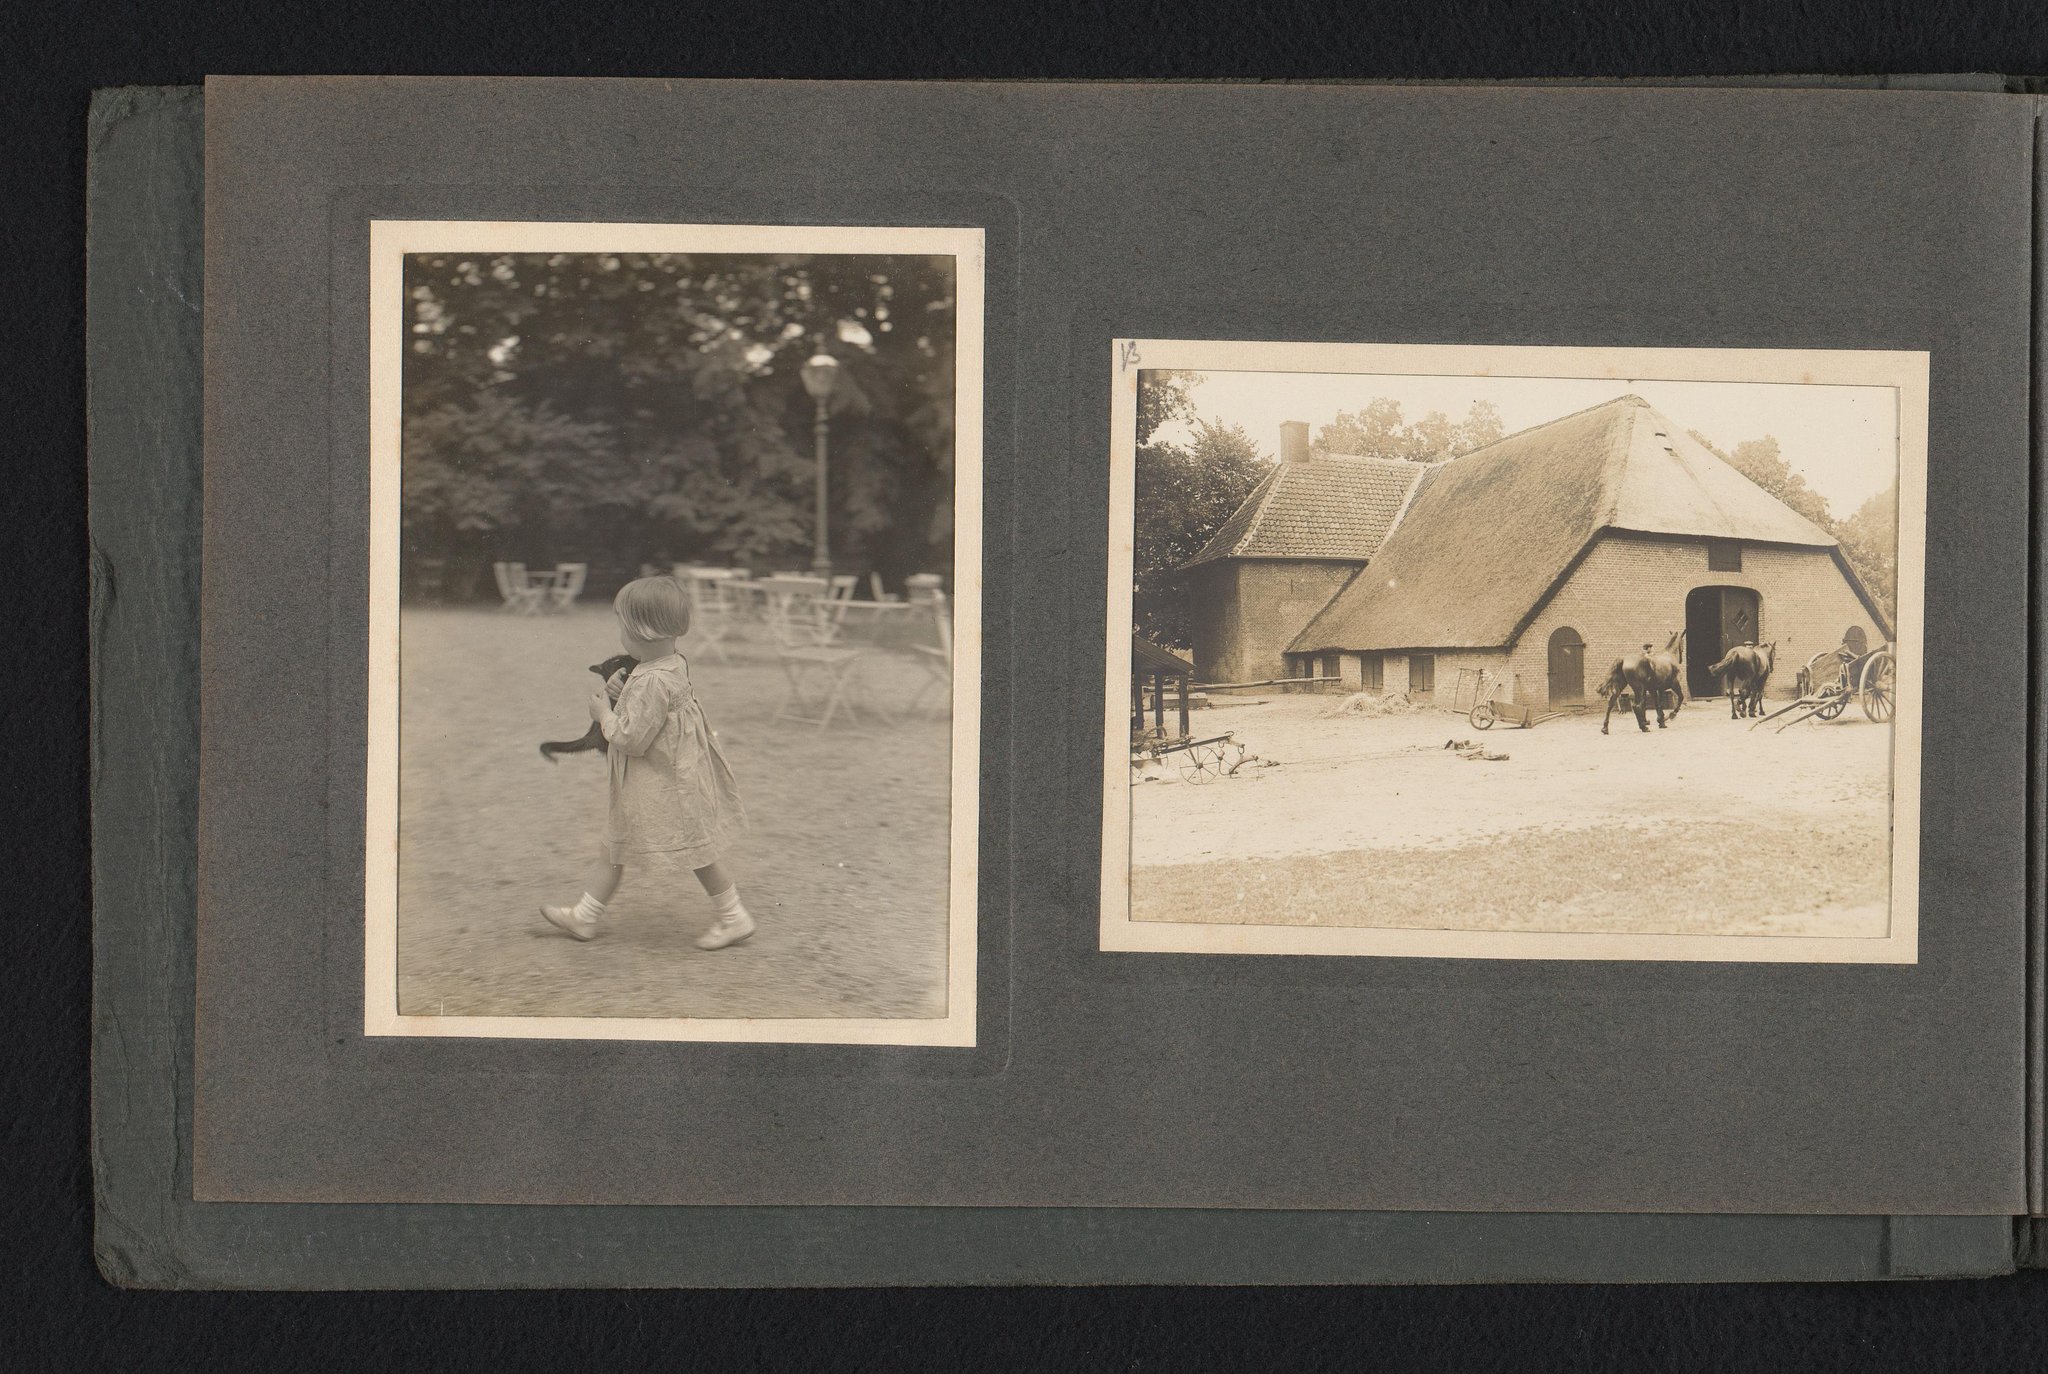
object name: photograph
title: Gezicht op een boerderij in Klarenbeek, links Carel van den Berg met een poes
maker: hendrik herman van den berg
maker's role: amateurfotograaf, jurist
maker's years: 1875-1944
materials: paper, cardboard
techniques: gelatin silver print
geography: klarenbeek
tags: carel frederik van den berg (cay), cat, farm (building)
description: Deze foto's zijn onderdeel van een album.